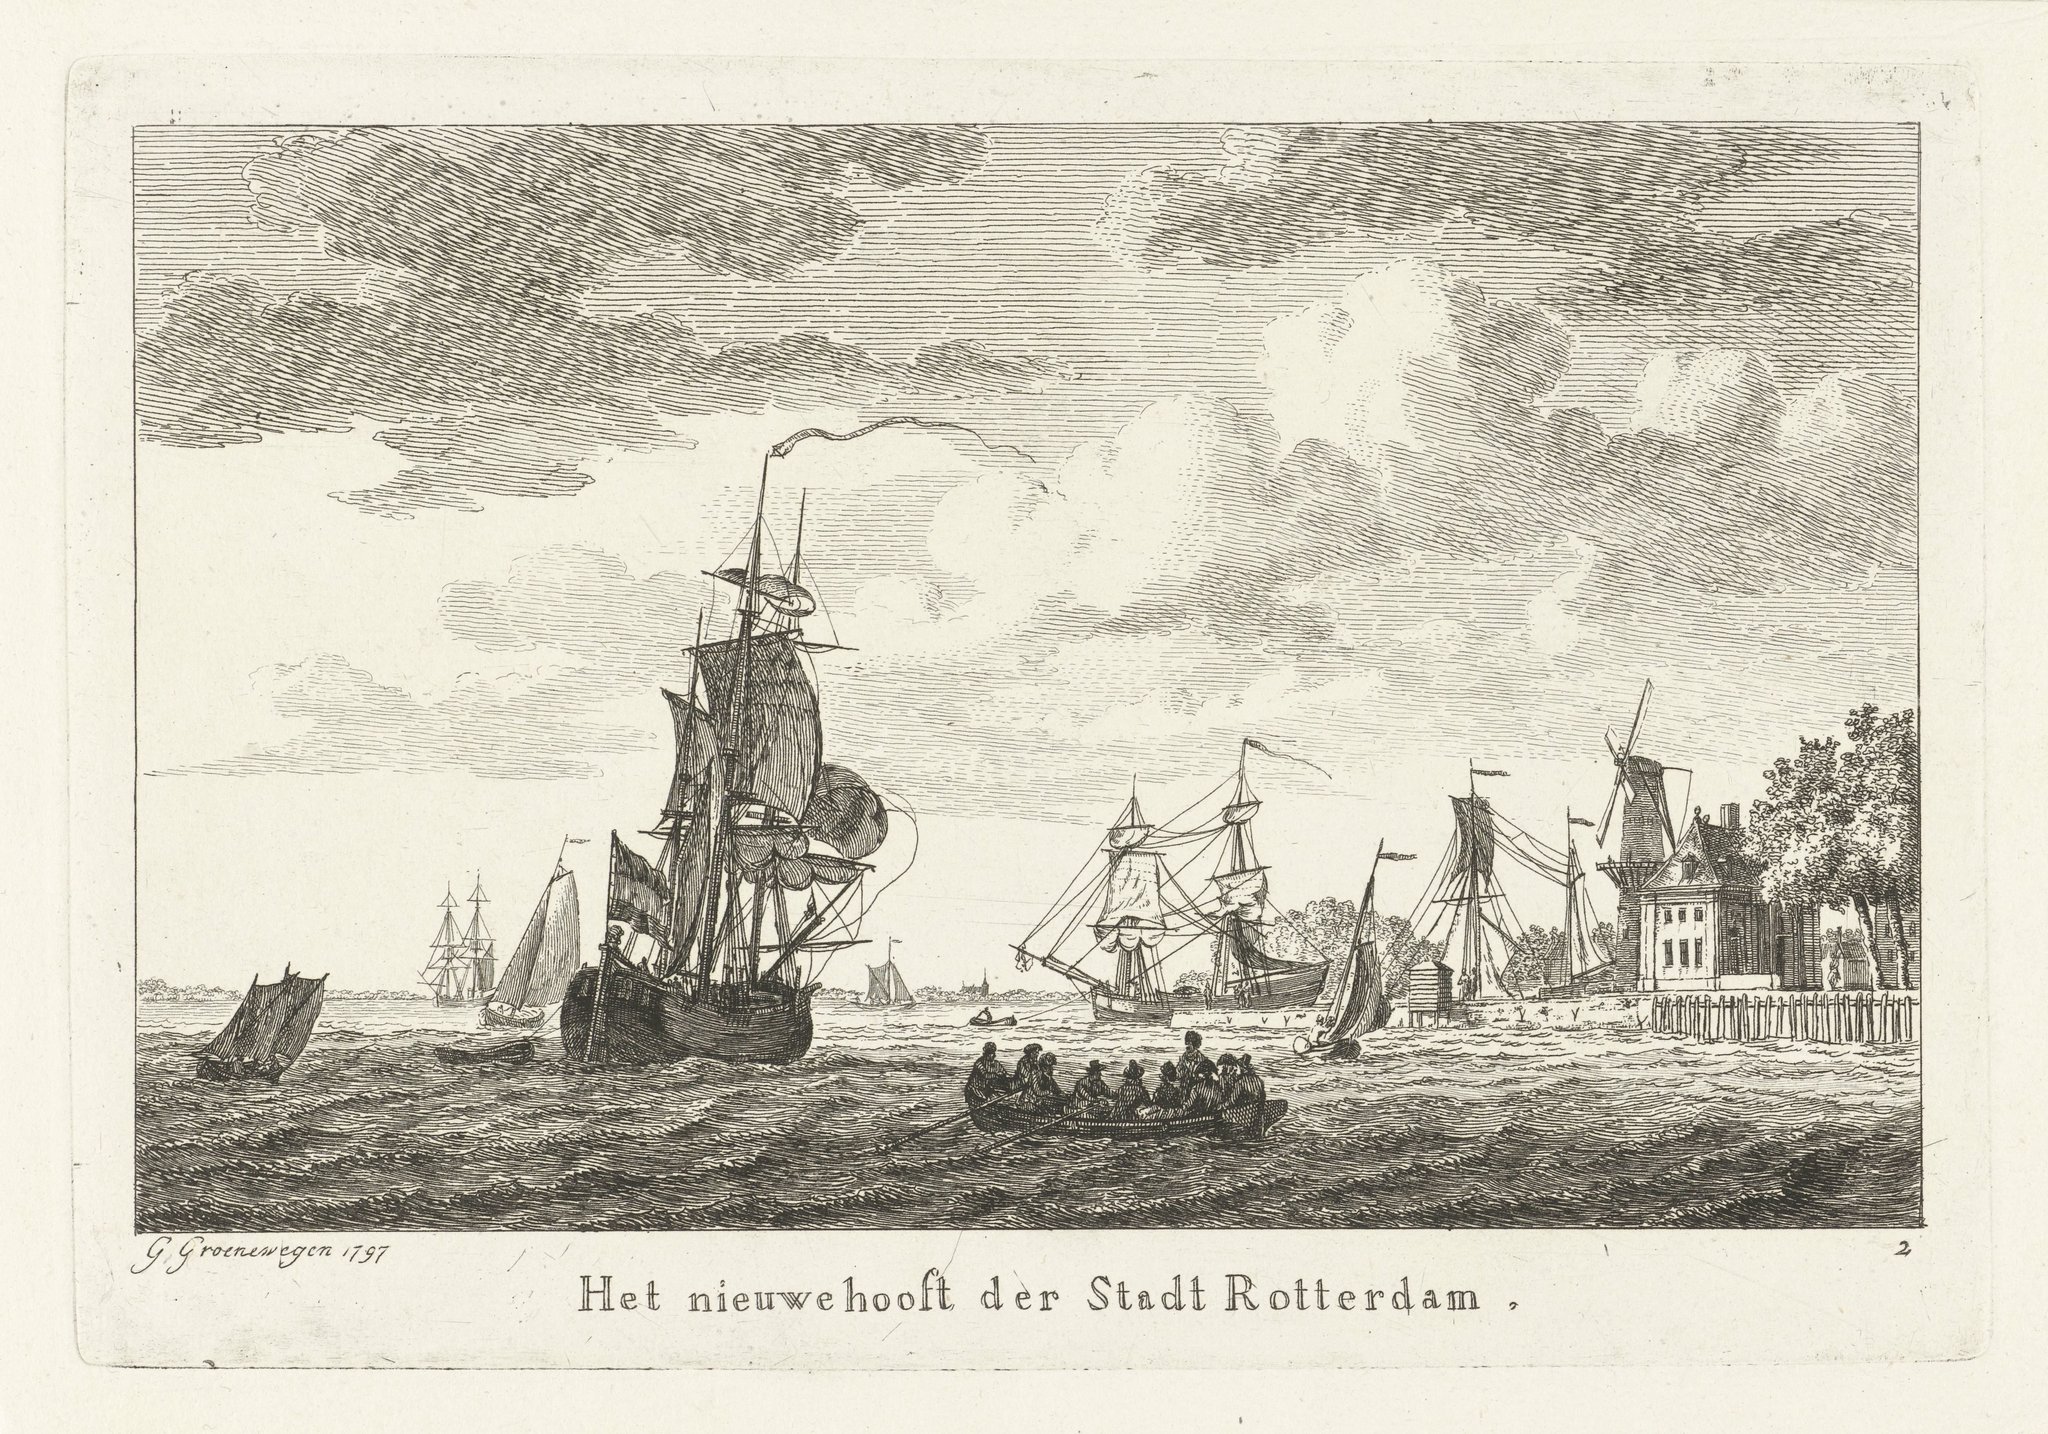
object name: print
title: Gezicht op het hoofd van de Leuvehaven te Rotterdam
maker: gerrit groenewegen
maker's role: draughtsman, print maker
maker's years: 1754-1826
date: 1797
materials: paper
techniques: etching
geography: rotterdam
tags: harbour, sailing-ship, sailing-boat, rowing-boat, canoe, etc., windmill, city-gate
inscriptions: collector's mark: Lugt 2228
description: Gezicht op het hoofd van de Leuvehaven aan de Maas te Rotterdam, ook wel het Nieuwe Hoofd genoemd. Op de voorgrond een roeiboot en een aantal zeilschepen. Rechts de Ooster Nieuwe Hoofdpoort, daarachter molen 'de Pelicaan'. Rechtsonder genummerd: 2. Deze prent maakt deel uit van een serie van zes prenten met Maasgezichten.